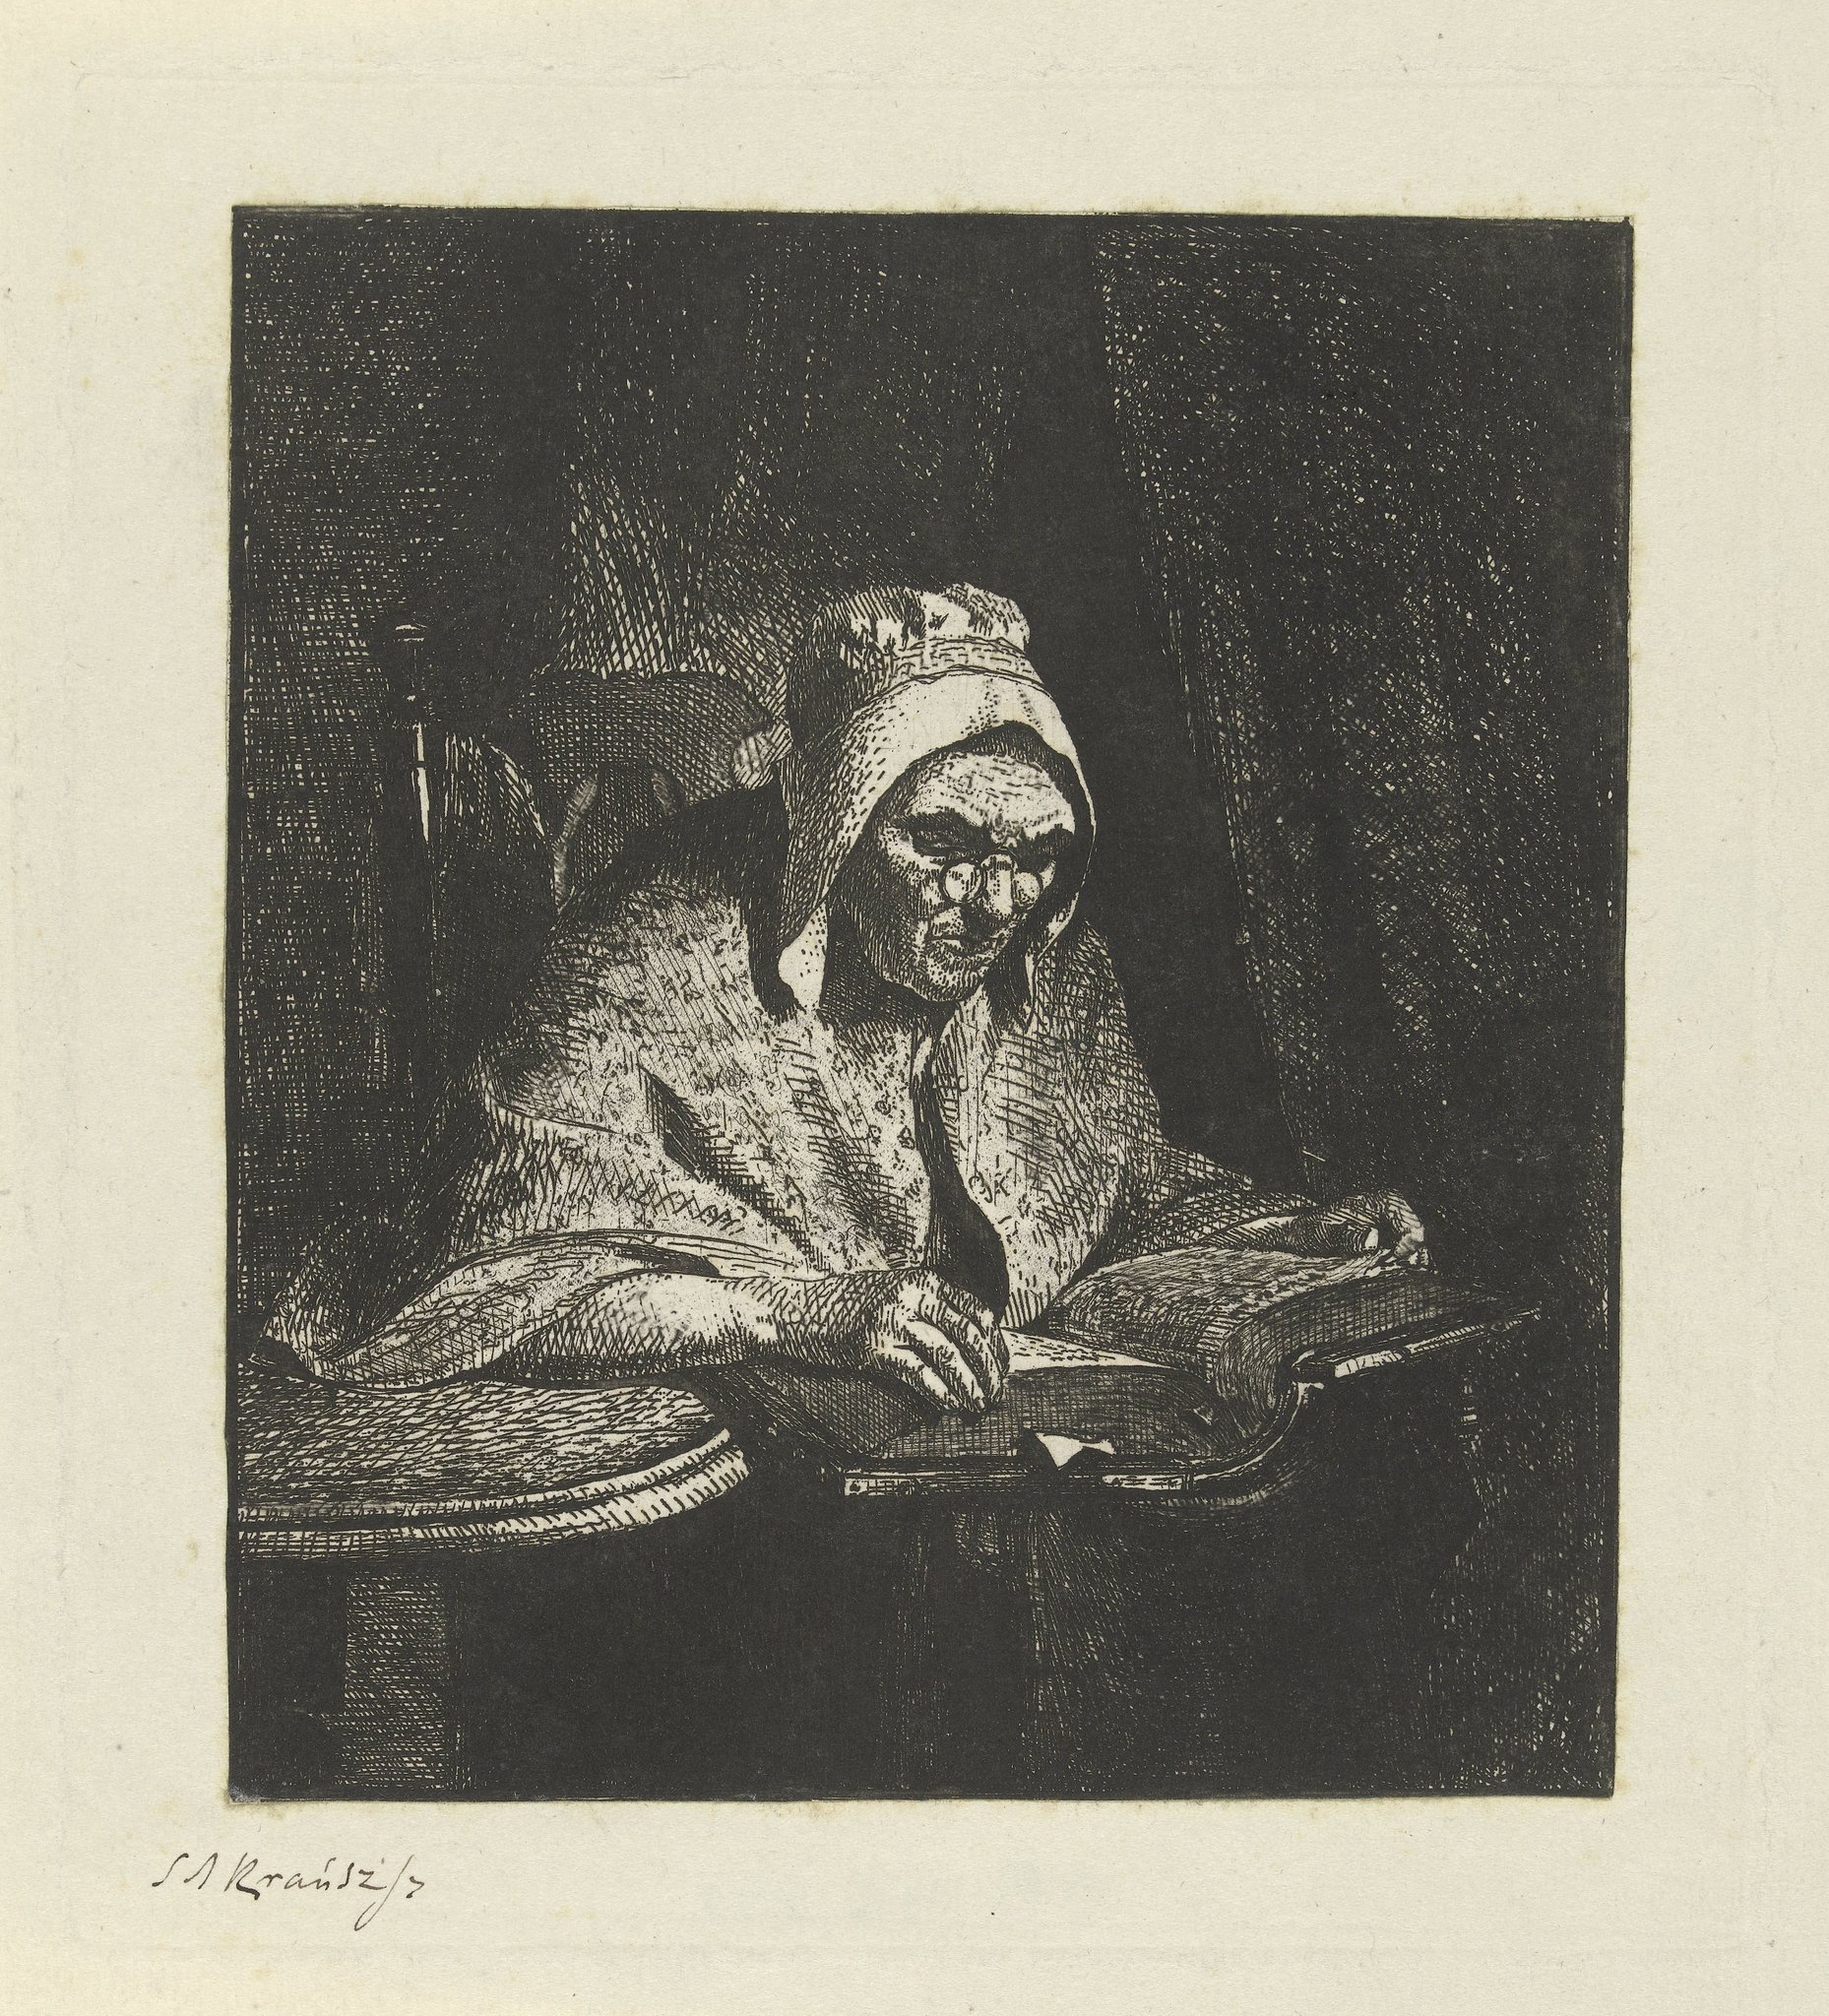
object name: print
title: Lezende oude vrouw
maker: simon andreas krausz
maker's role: draughtsman, print maker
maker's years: 1760-1825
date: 1770-1825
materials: paper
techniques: etching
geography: the hague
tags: eyeglasses, spectacles, old woman, reading the bible or other religious books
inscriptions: inscription: ‘SA Krausz fec.’, collector's mark: Lugt 2228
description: In een donker vertrek leest een oude vrouw, met knijpbril op de neus, in een dik boek (de bijbel).